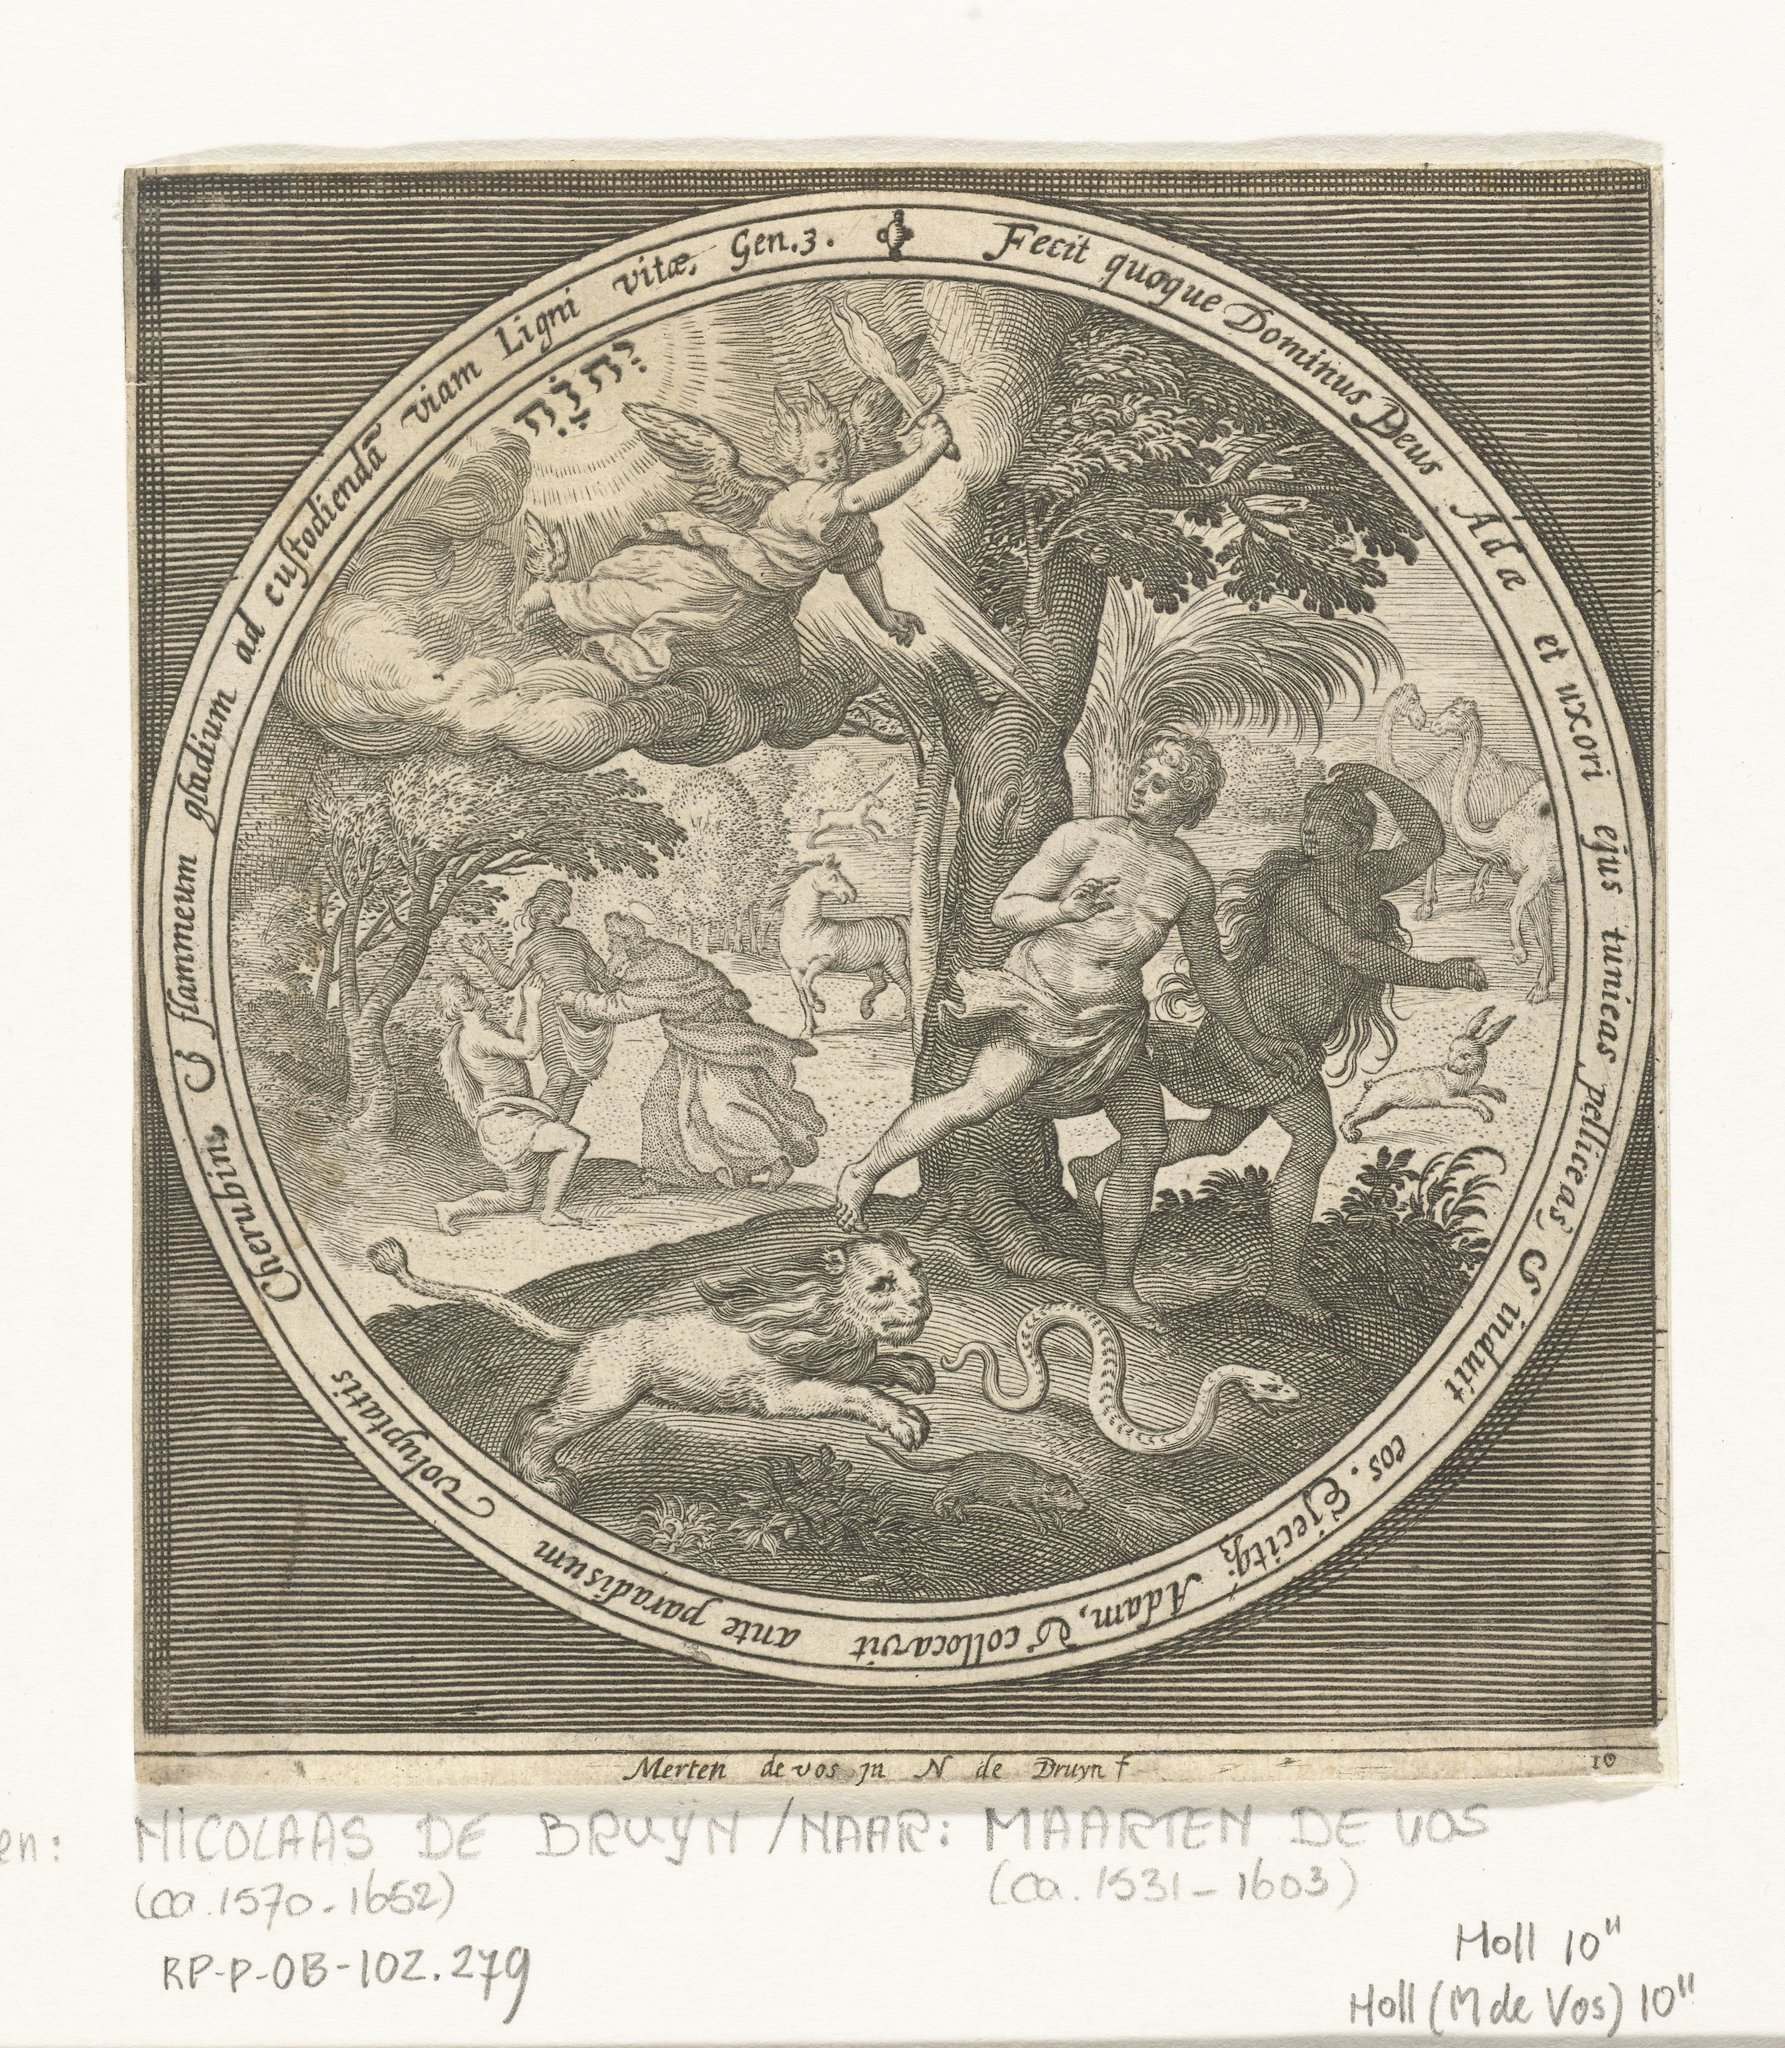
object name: print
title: Expulsion from Paradise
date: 1581-1656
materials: paper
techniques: engraving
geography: netherlands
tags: god expels adam and eve from paradise and has the tree of life guarded by an angel with a flaming sword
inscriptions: collector's mark: Lugt 2228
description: Adam en Eva worden door engel met vlammend zwaard weggejaagd uit het paradijs. In medaillon met als opschrift een bijbeltekst in Latijn uit Genesis 3 binnen rechthoekige omlijsting.